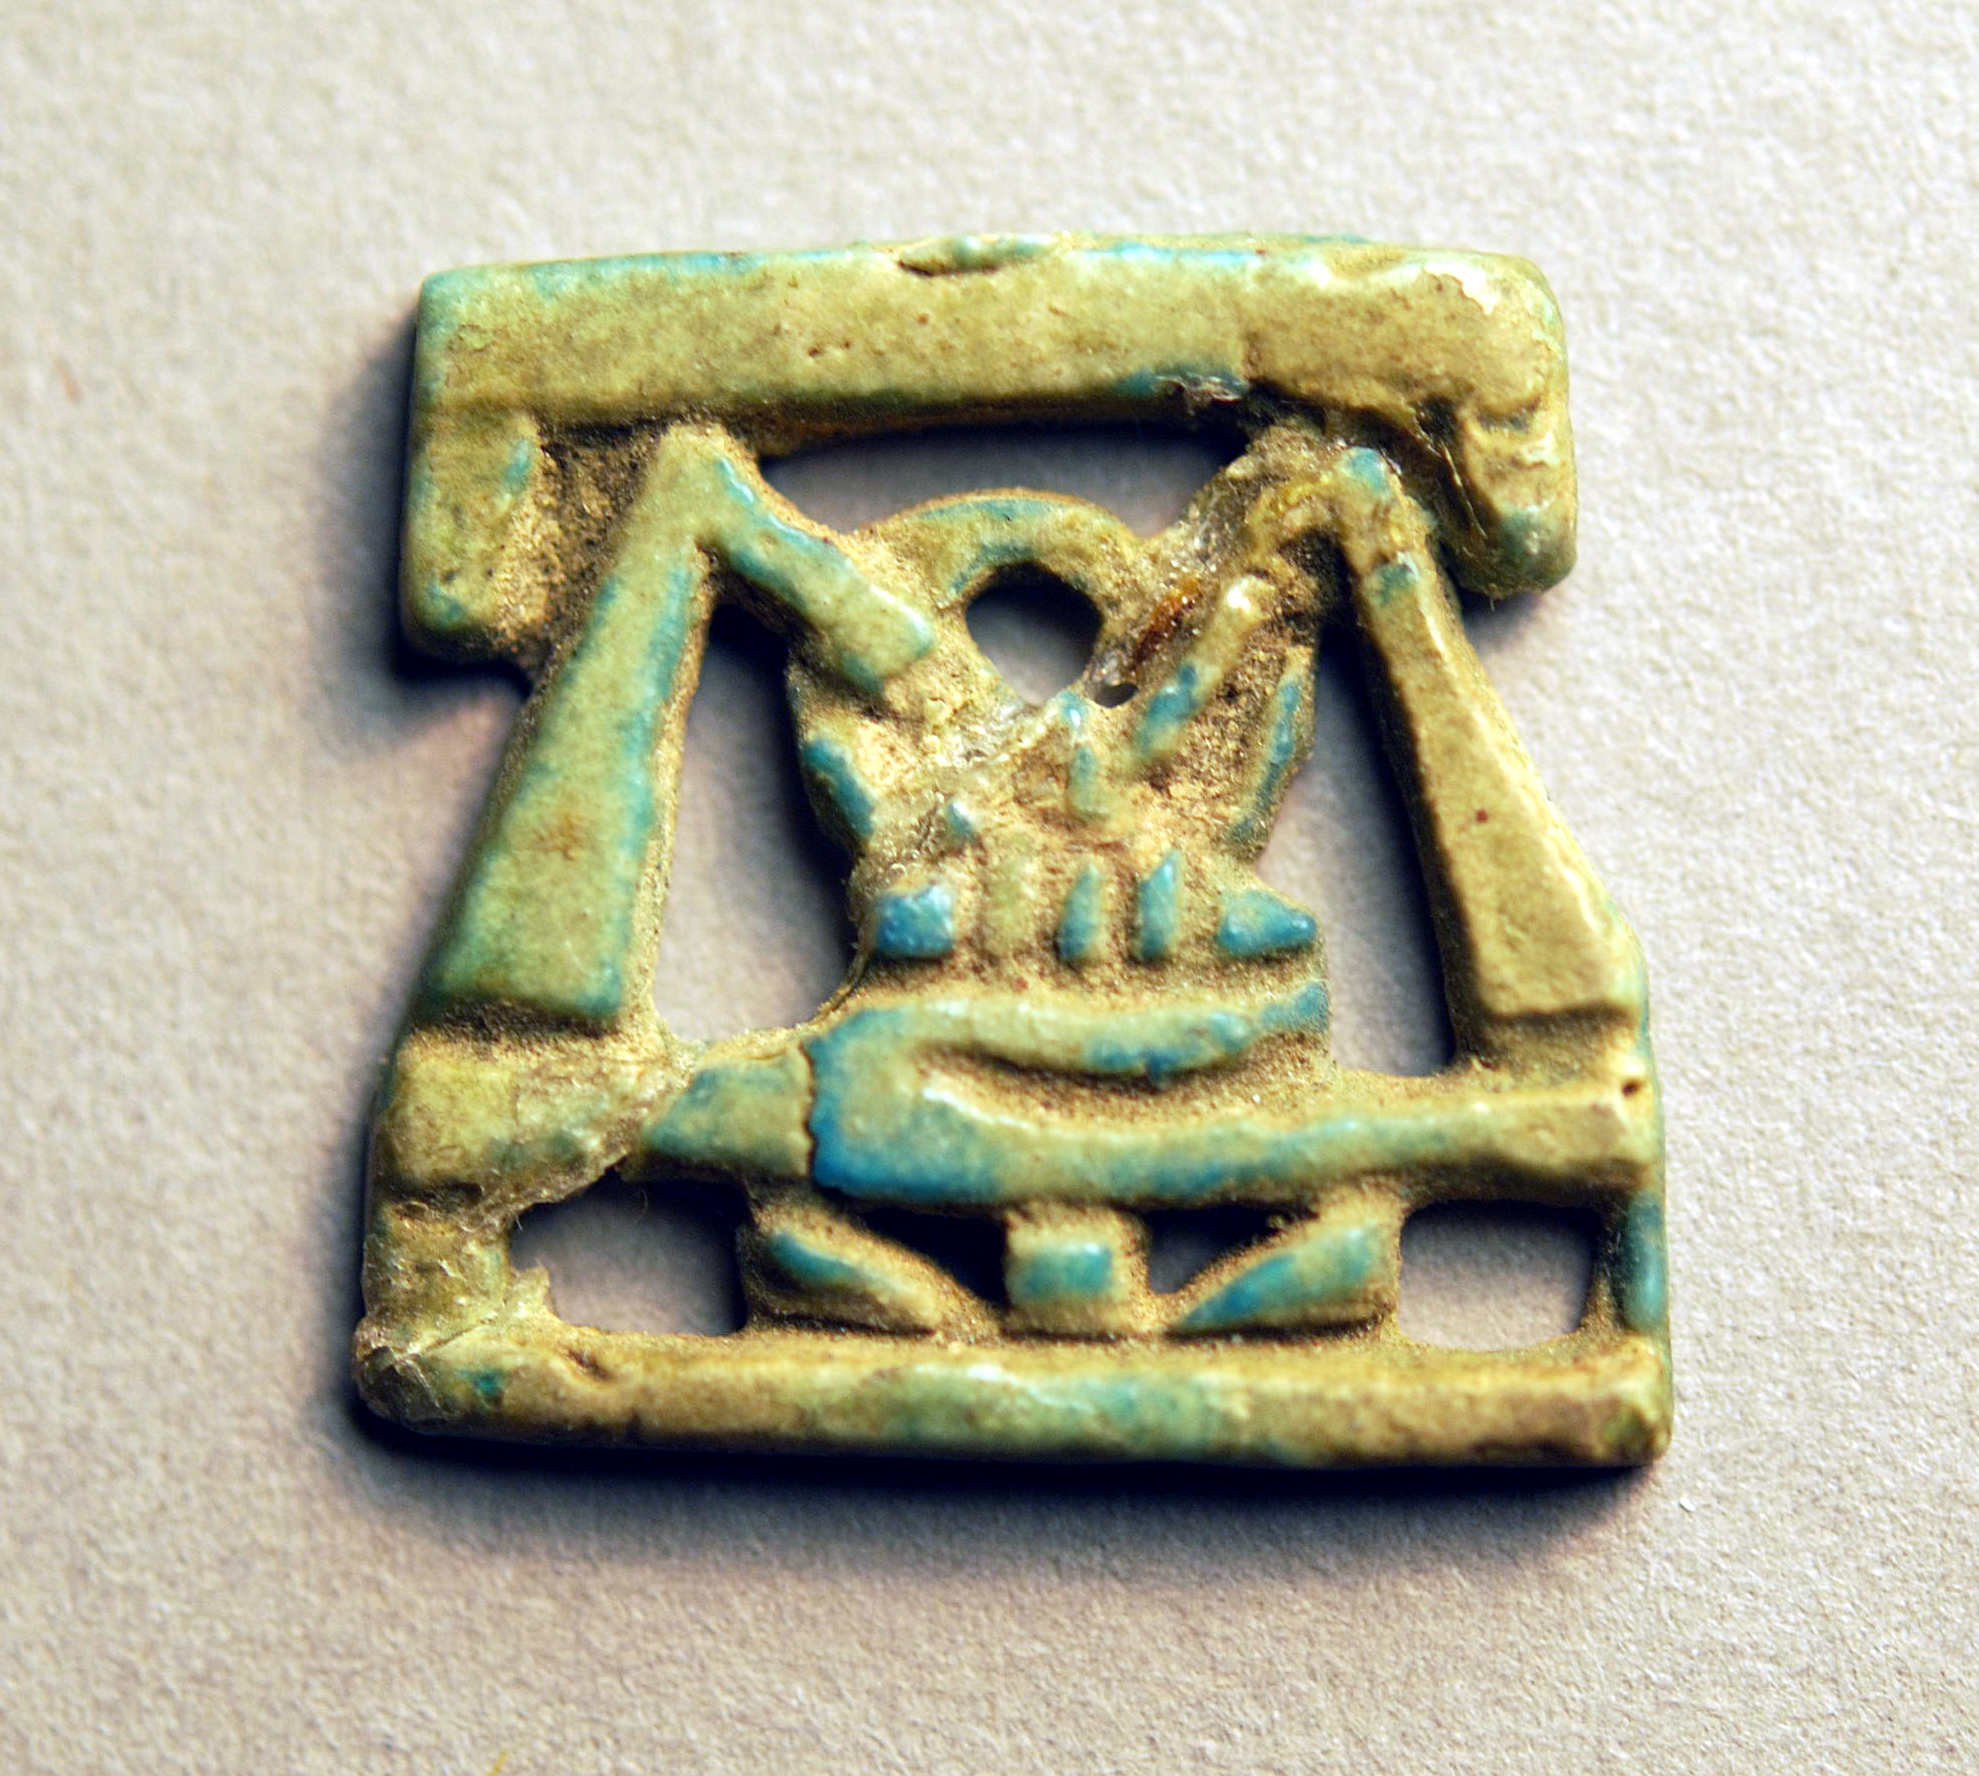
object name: amulet, hieroglyphic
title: Hieroglyphic Amulet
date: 1390-1352 BCE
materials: faience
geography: egypt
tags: hieroglyphs